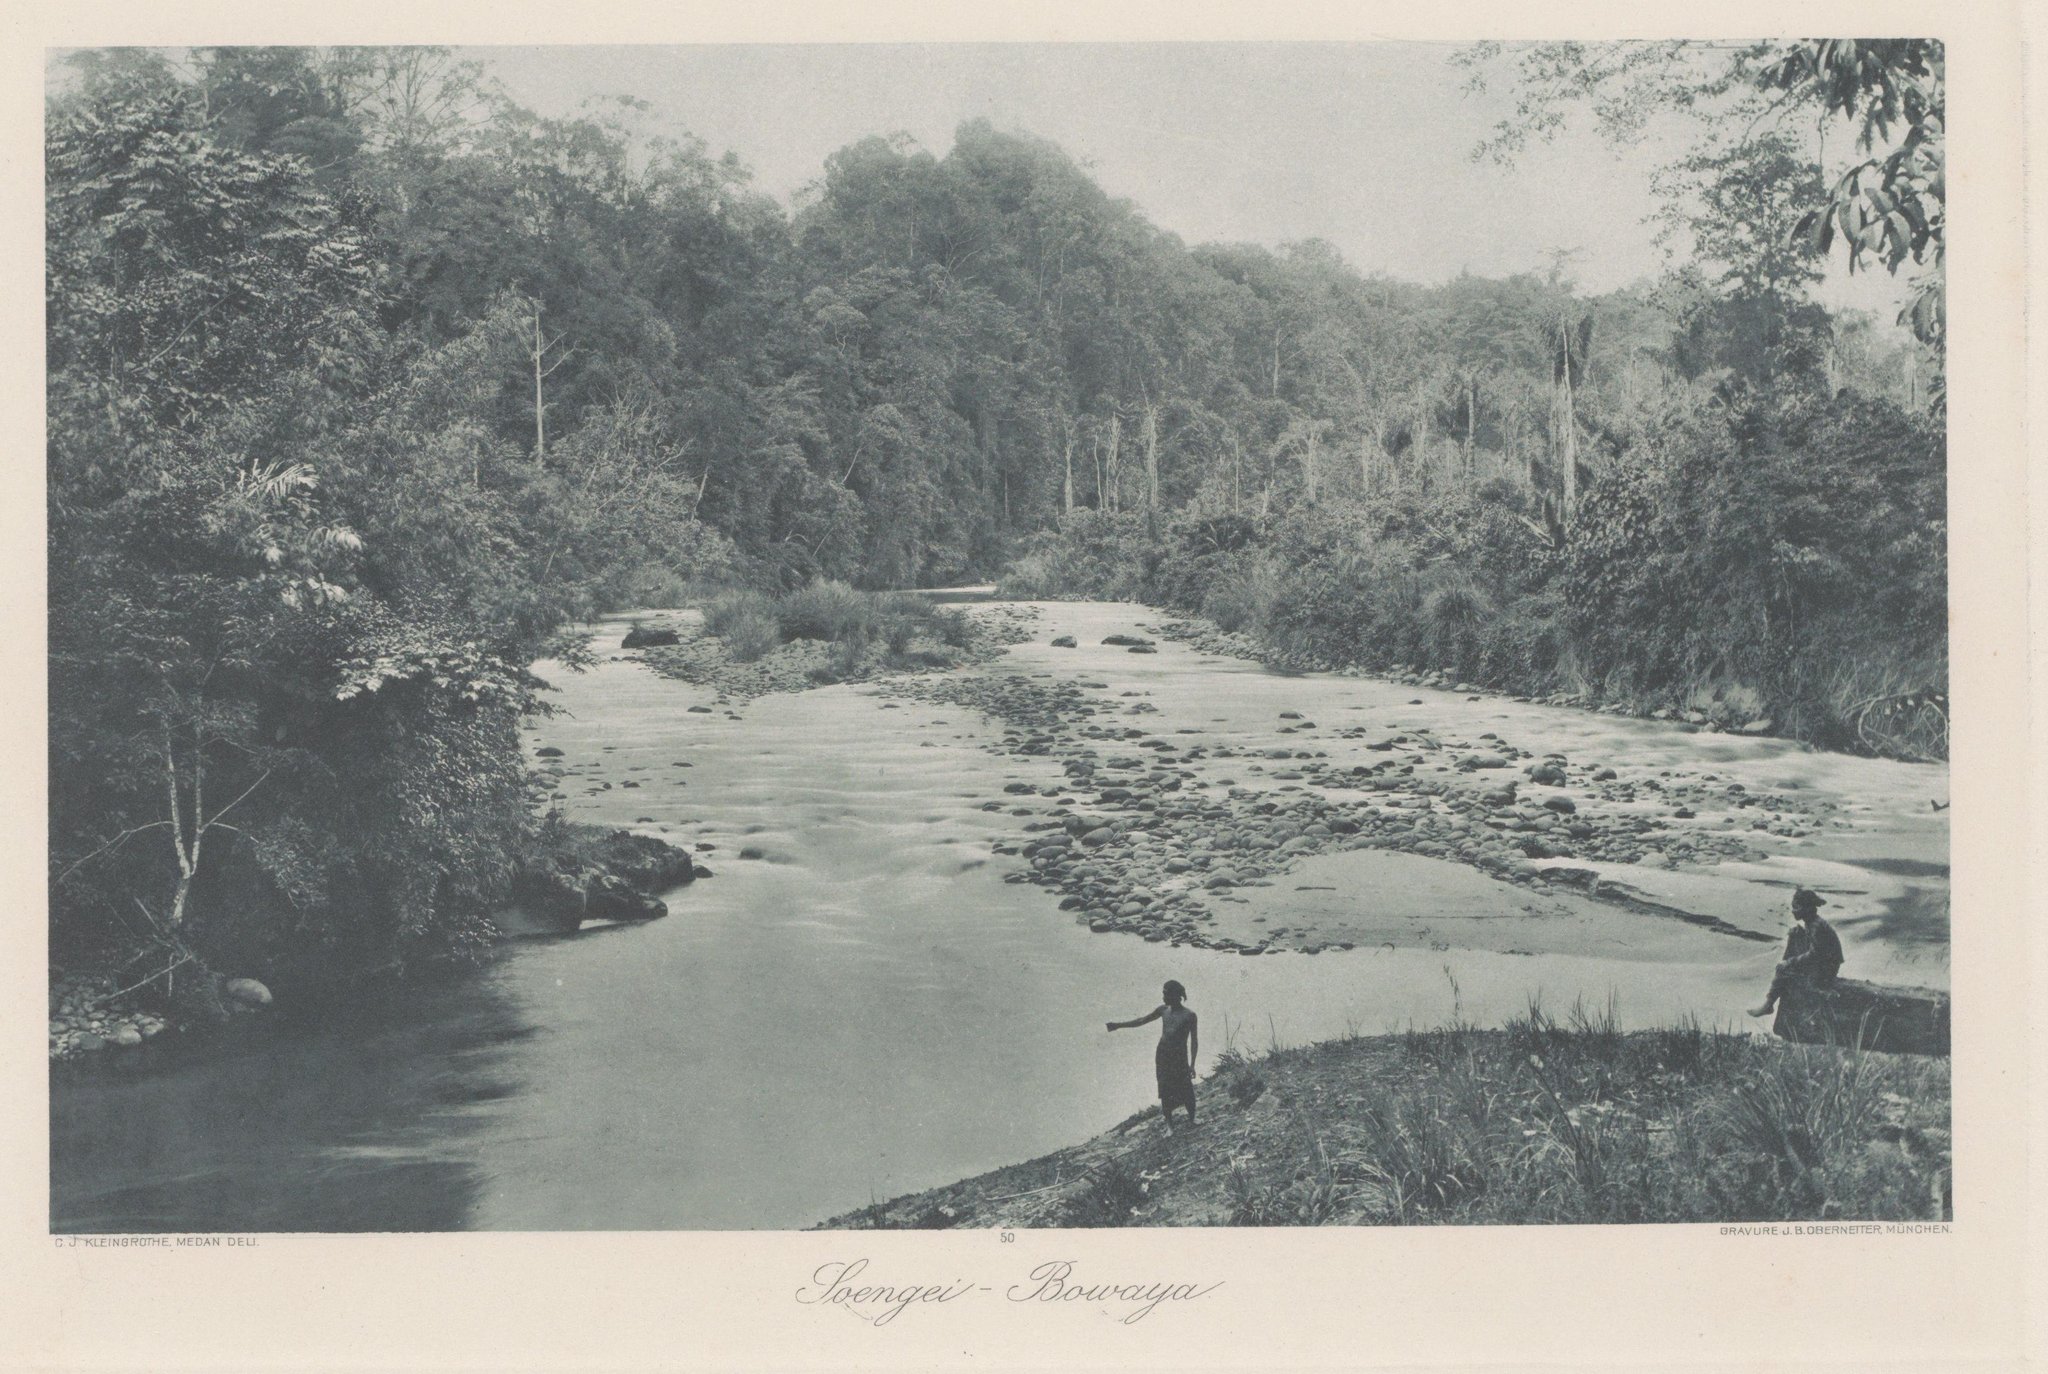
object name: photomechanical print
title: Soengei - Bowaya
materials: paper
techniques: photoaquatint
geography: munich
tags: river bank, dry river, river bed, sumatra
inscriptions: number: ‘50’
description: Onderdeel van Album met heliogravures van Sumatra's oostkust.